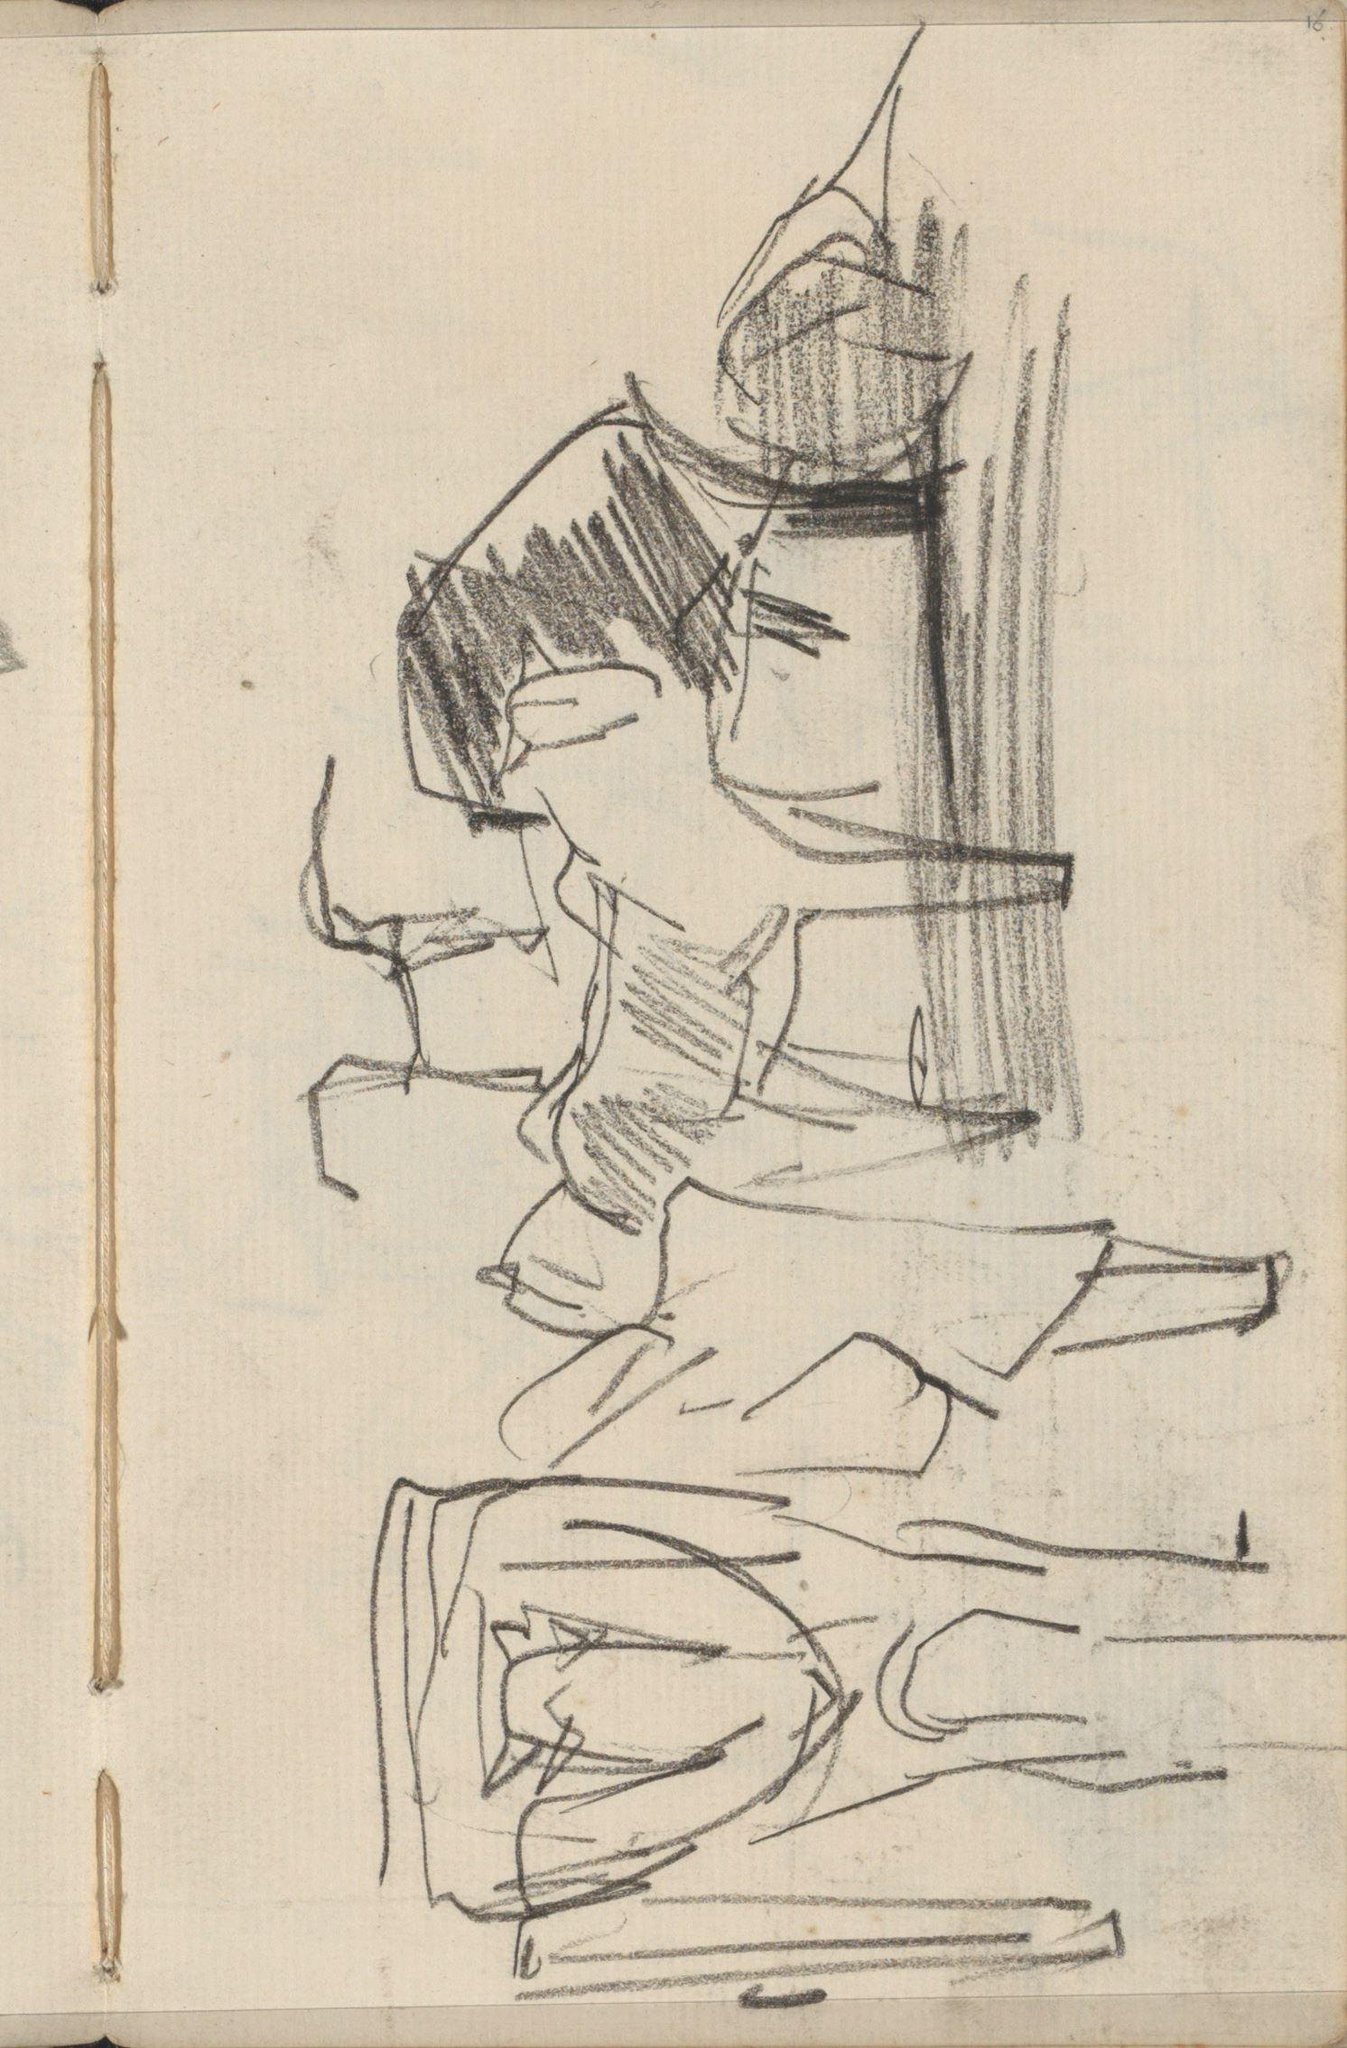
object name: sketchbook leaf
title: Paardenkarren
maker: george hendrik breitner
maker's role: draughtsman, painter, print maker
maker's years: 1857-1923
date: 1884-1886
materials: chalk, paper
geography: paris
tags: two-wheeled, animal-drawn vehicle, horse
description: Pagina 16 uit een schetsboek met 25 bladen.